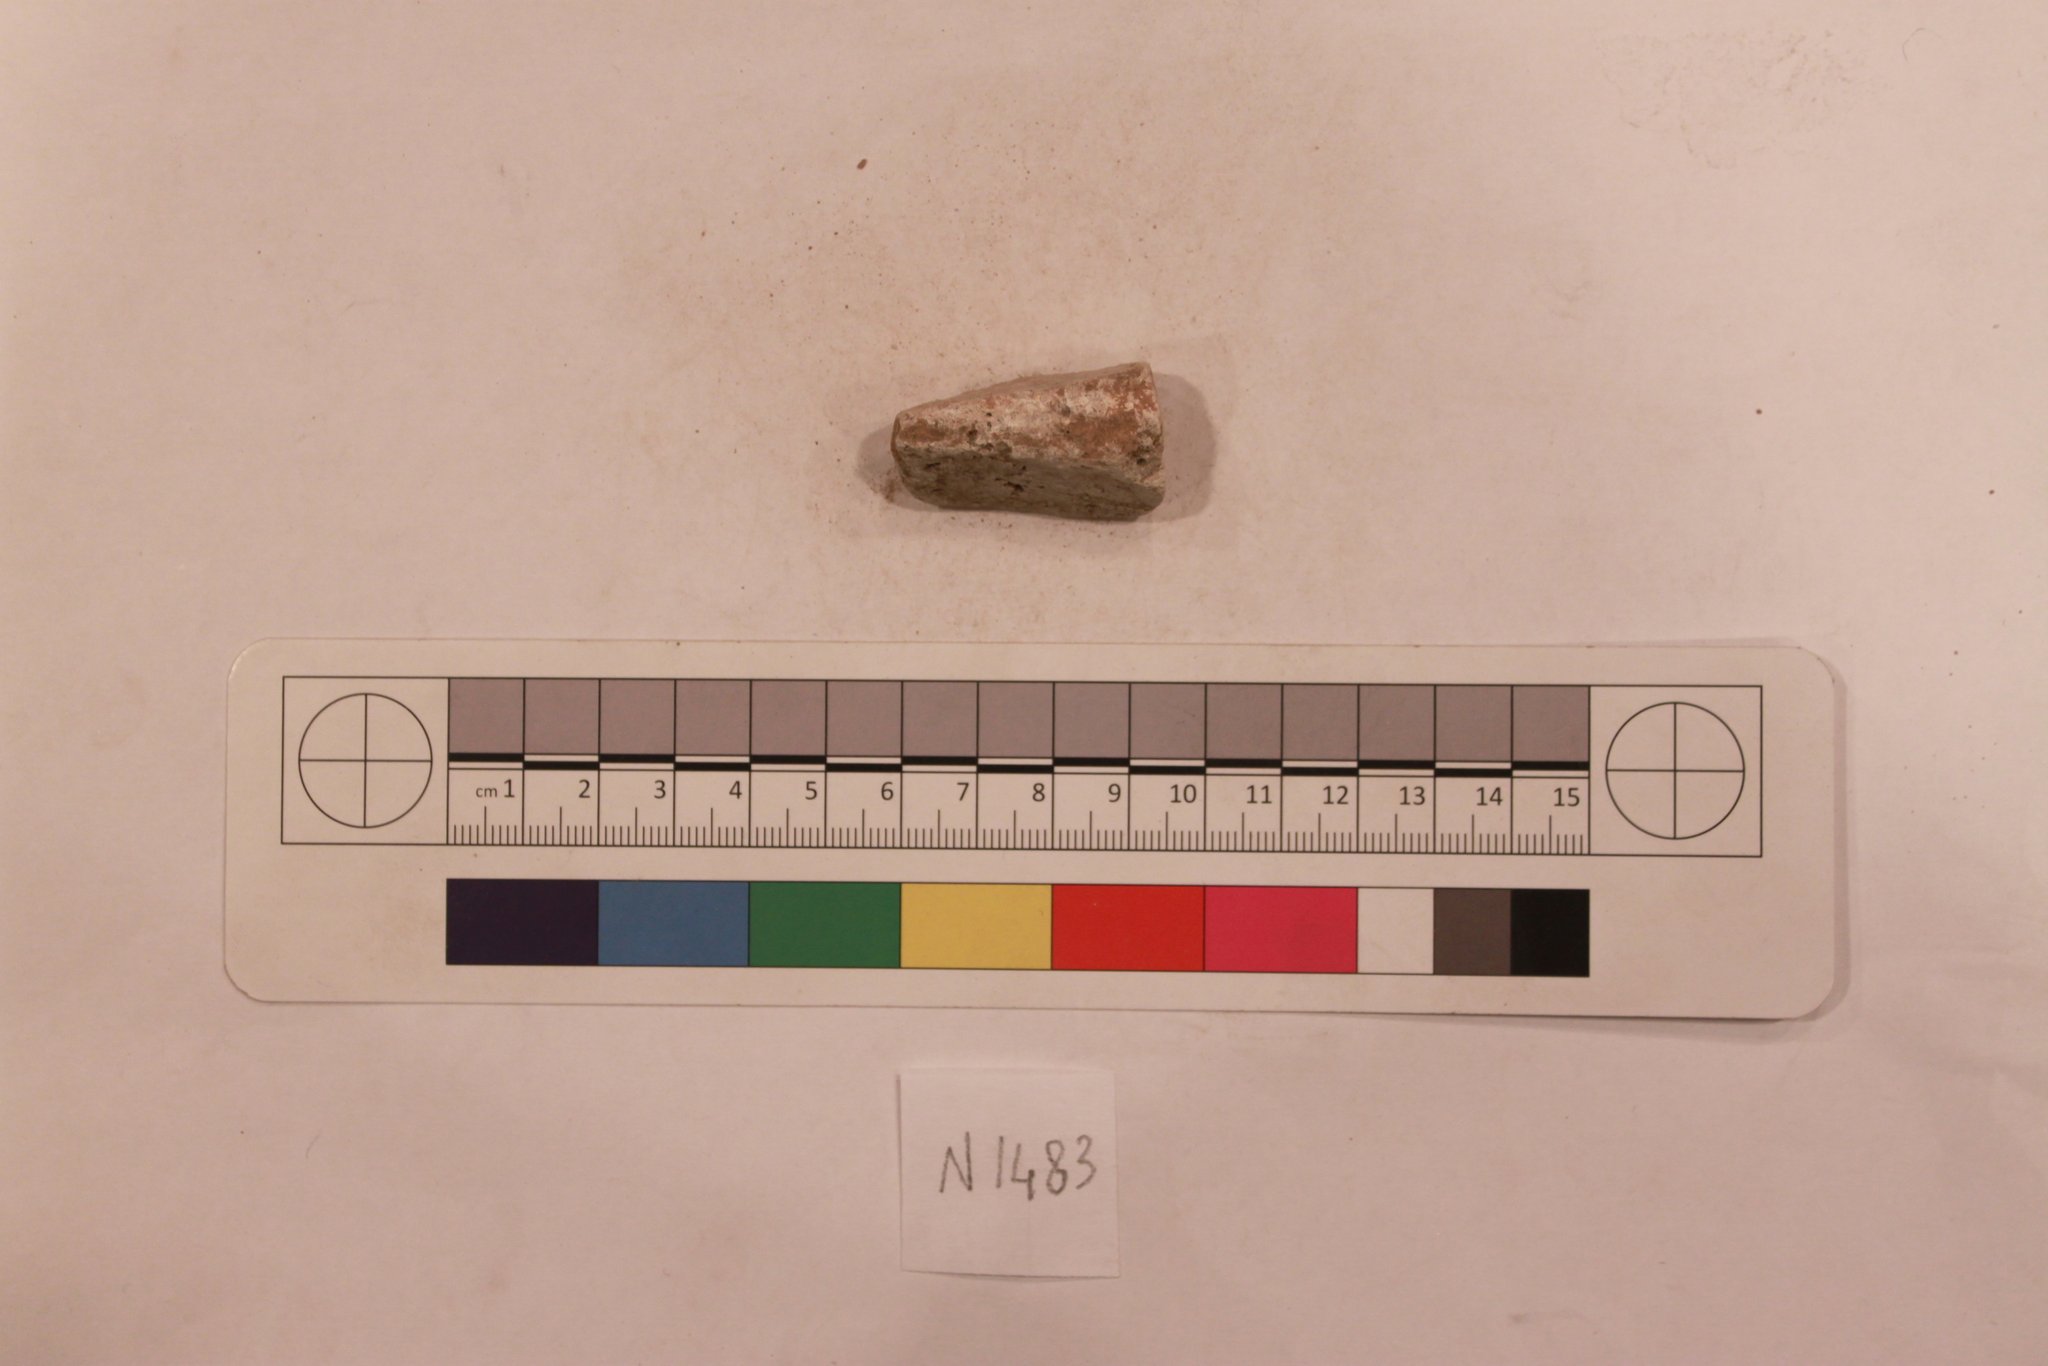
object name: fragment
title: Stucco Fragment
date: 701-1200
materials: plaster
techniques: carving, painting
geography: iran